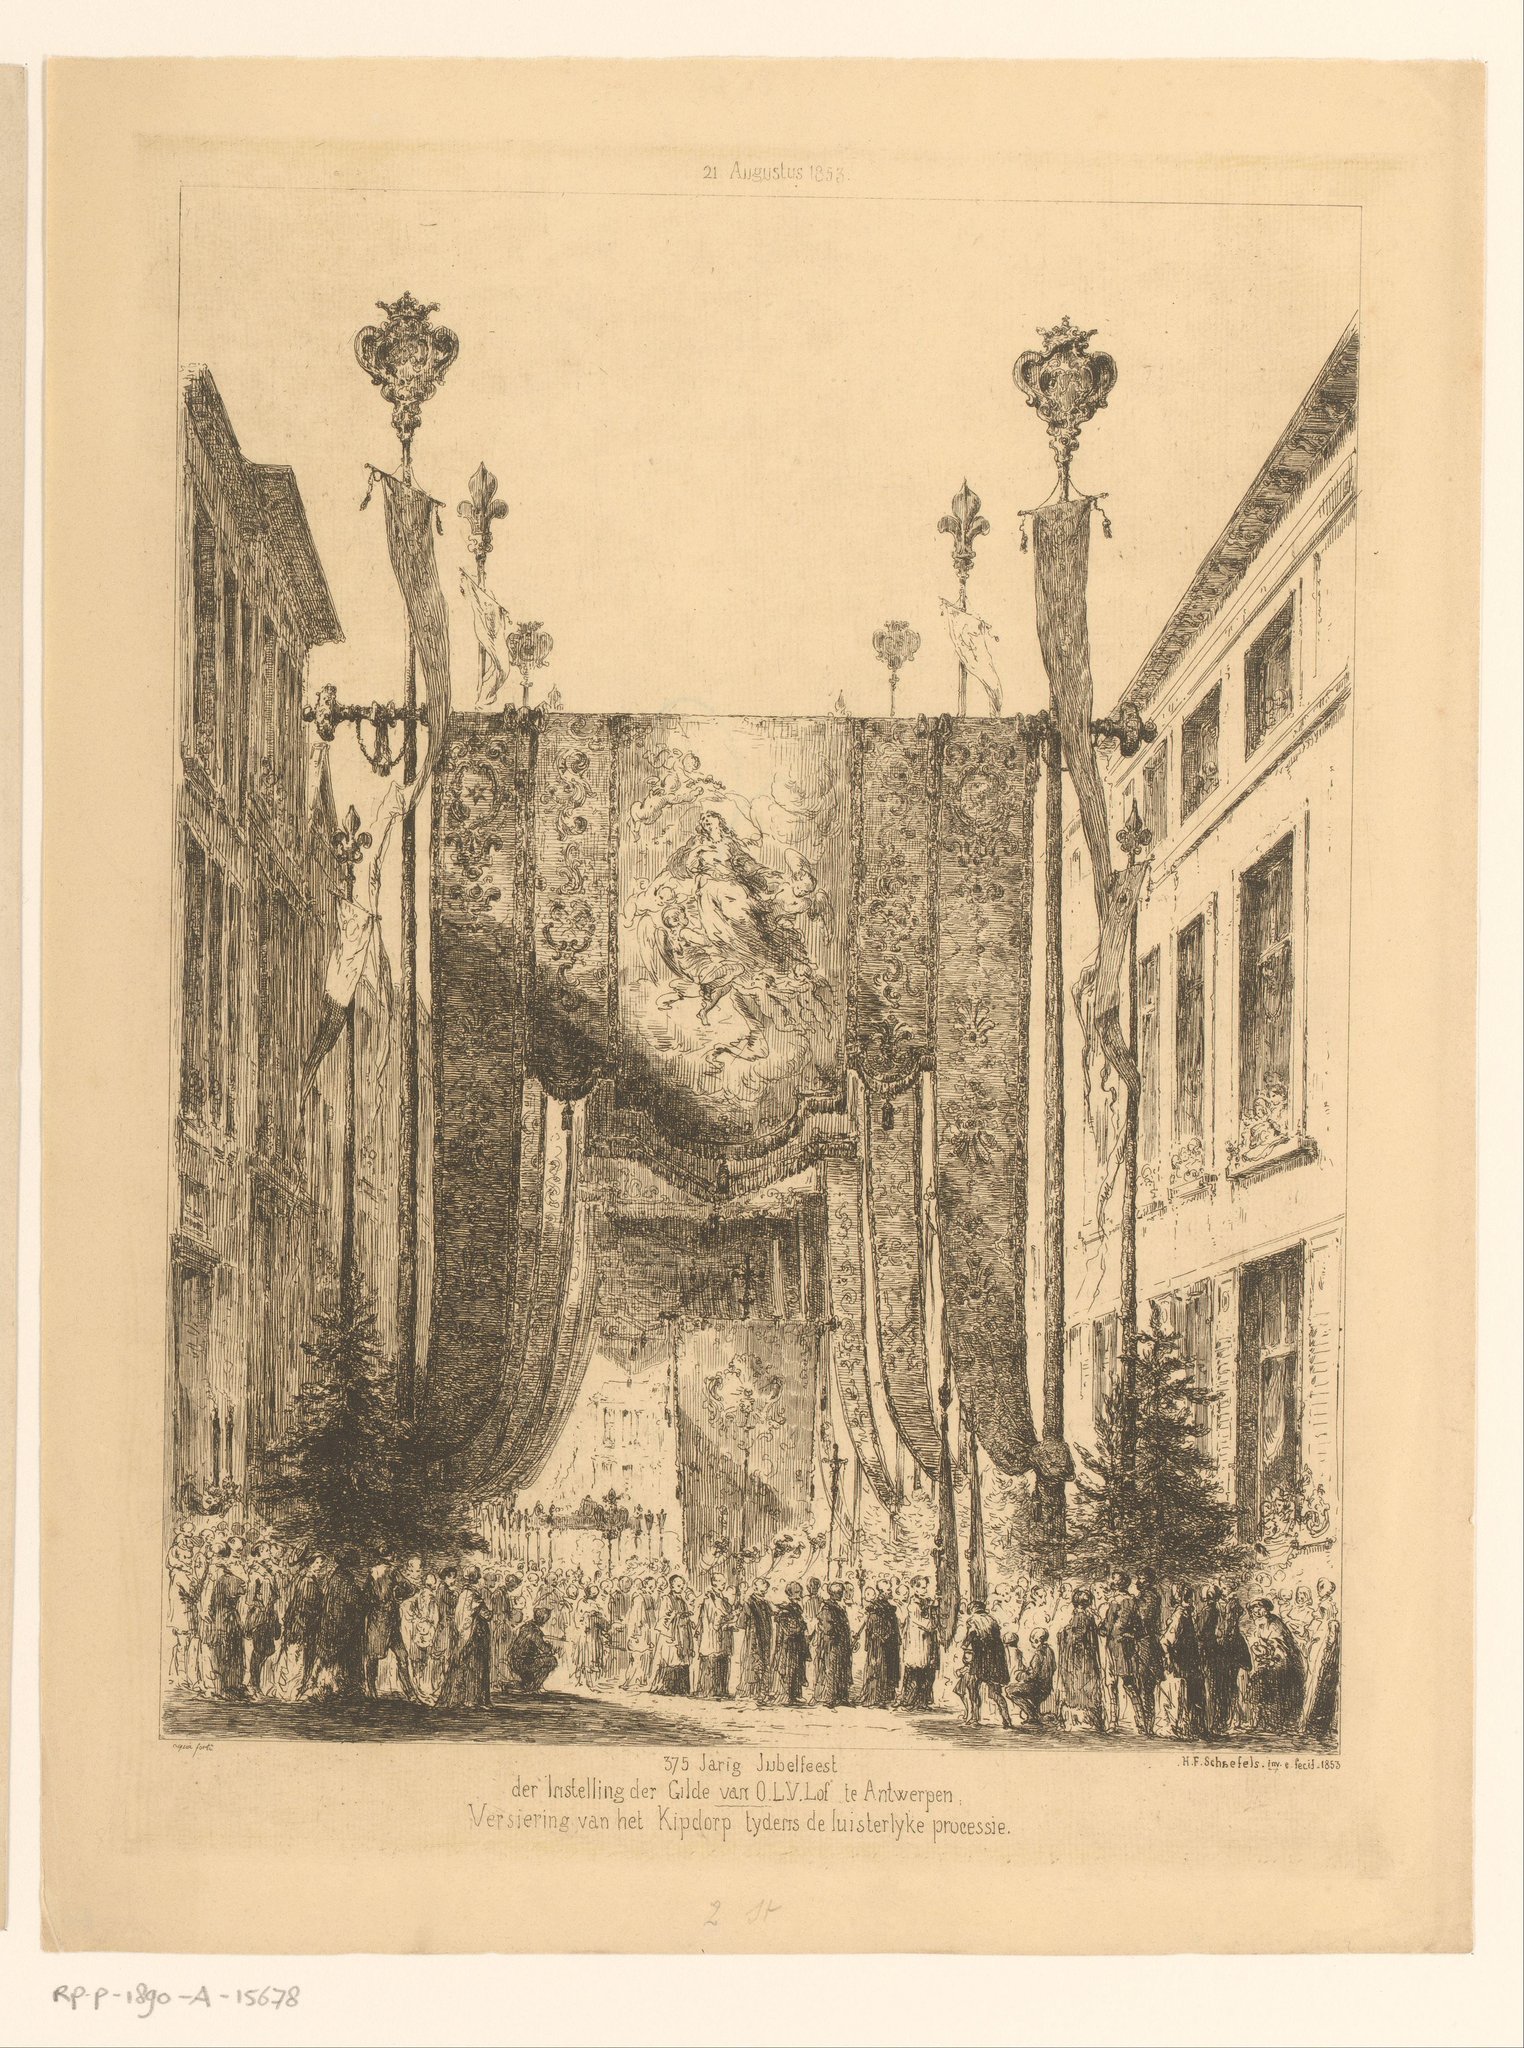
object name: print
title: 375 Jarig Jubelfeest der Instelling der Gilde van O.L.V. Lof (...) tydens de luisterlyke processie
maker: henri françois schaefels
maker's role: print maker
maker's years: 1827-1904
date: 1853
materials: paper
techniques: etching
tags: decoration and illumination of streets, squares, etc. (~ triumphal entry, etc.), procession ~ christian religion, street, antwerp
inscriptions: collector's mark: Lugt 2228